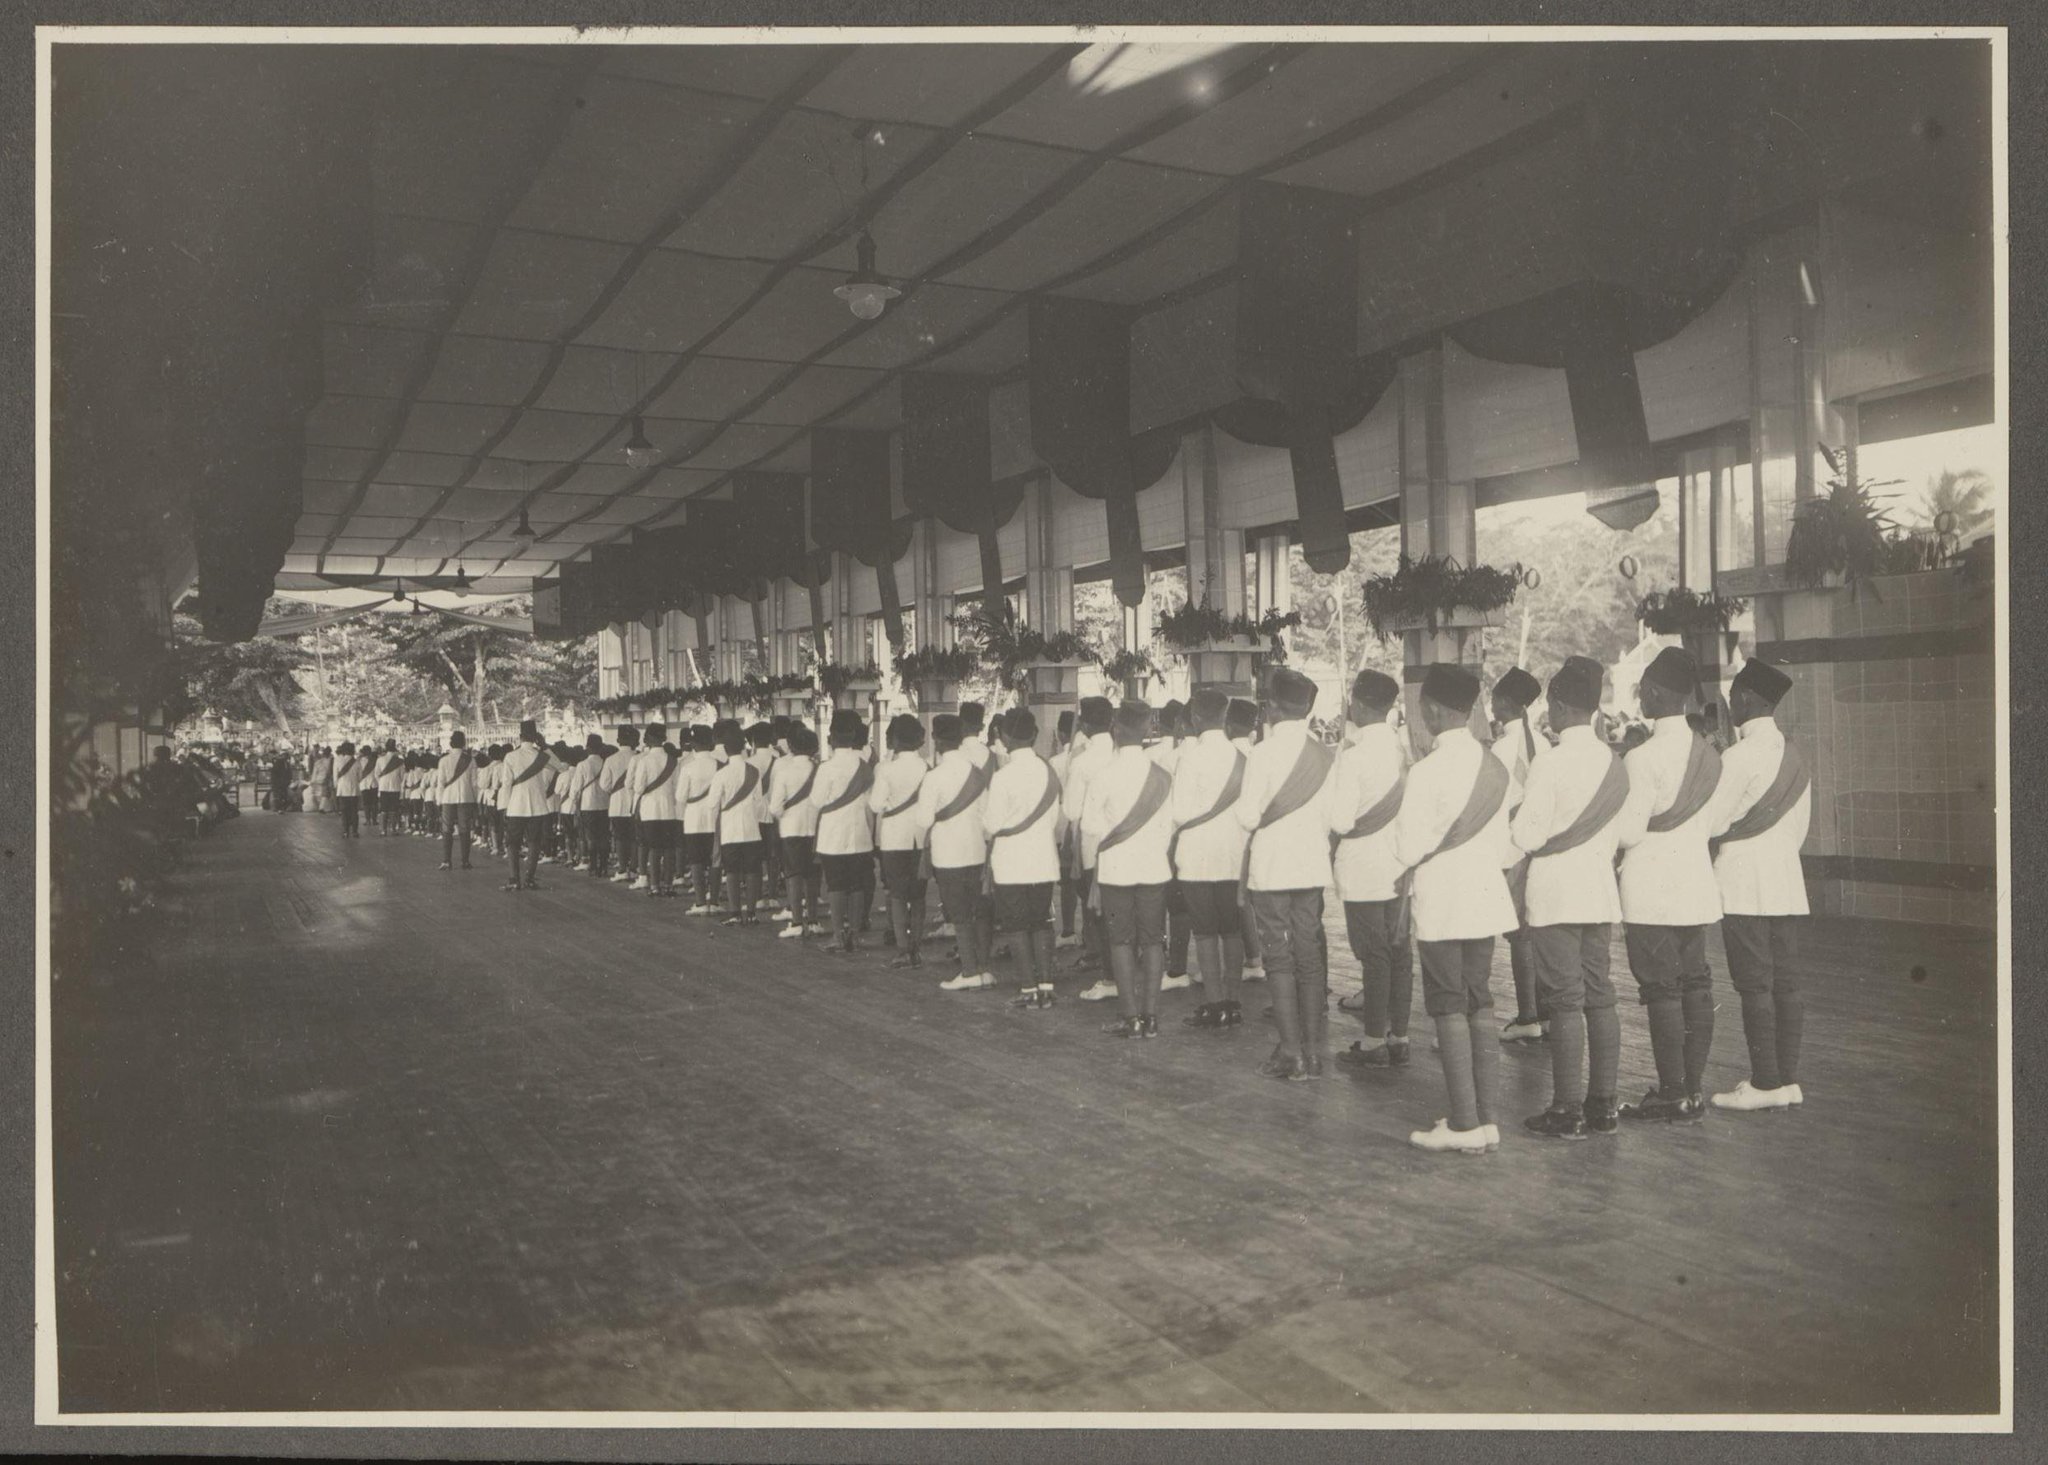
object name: photograph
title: Rij paramilitairen in de ontvangstzaal in het paleis van de Sultan van Langkat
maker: Anonymous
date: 1919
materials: photographic support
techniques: gelatin silver print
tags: palace - aa - civic architecture: inside, historical persons, sumatra